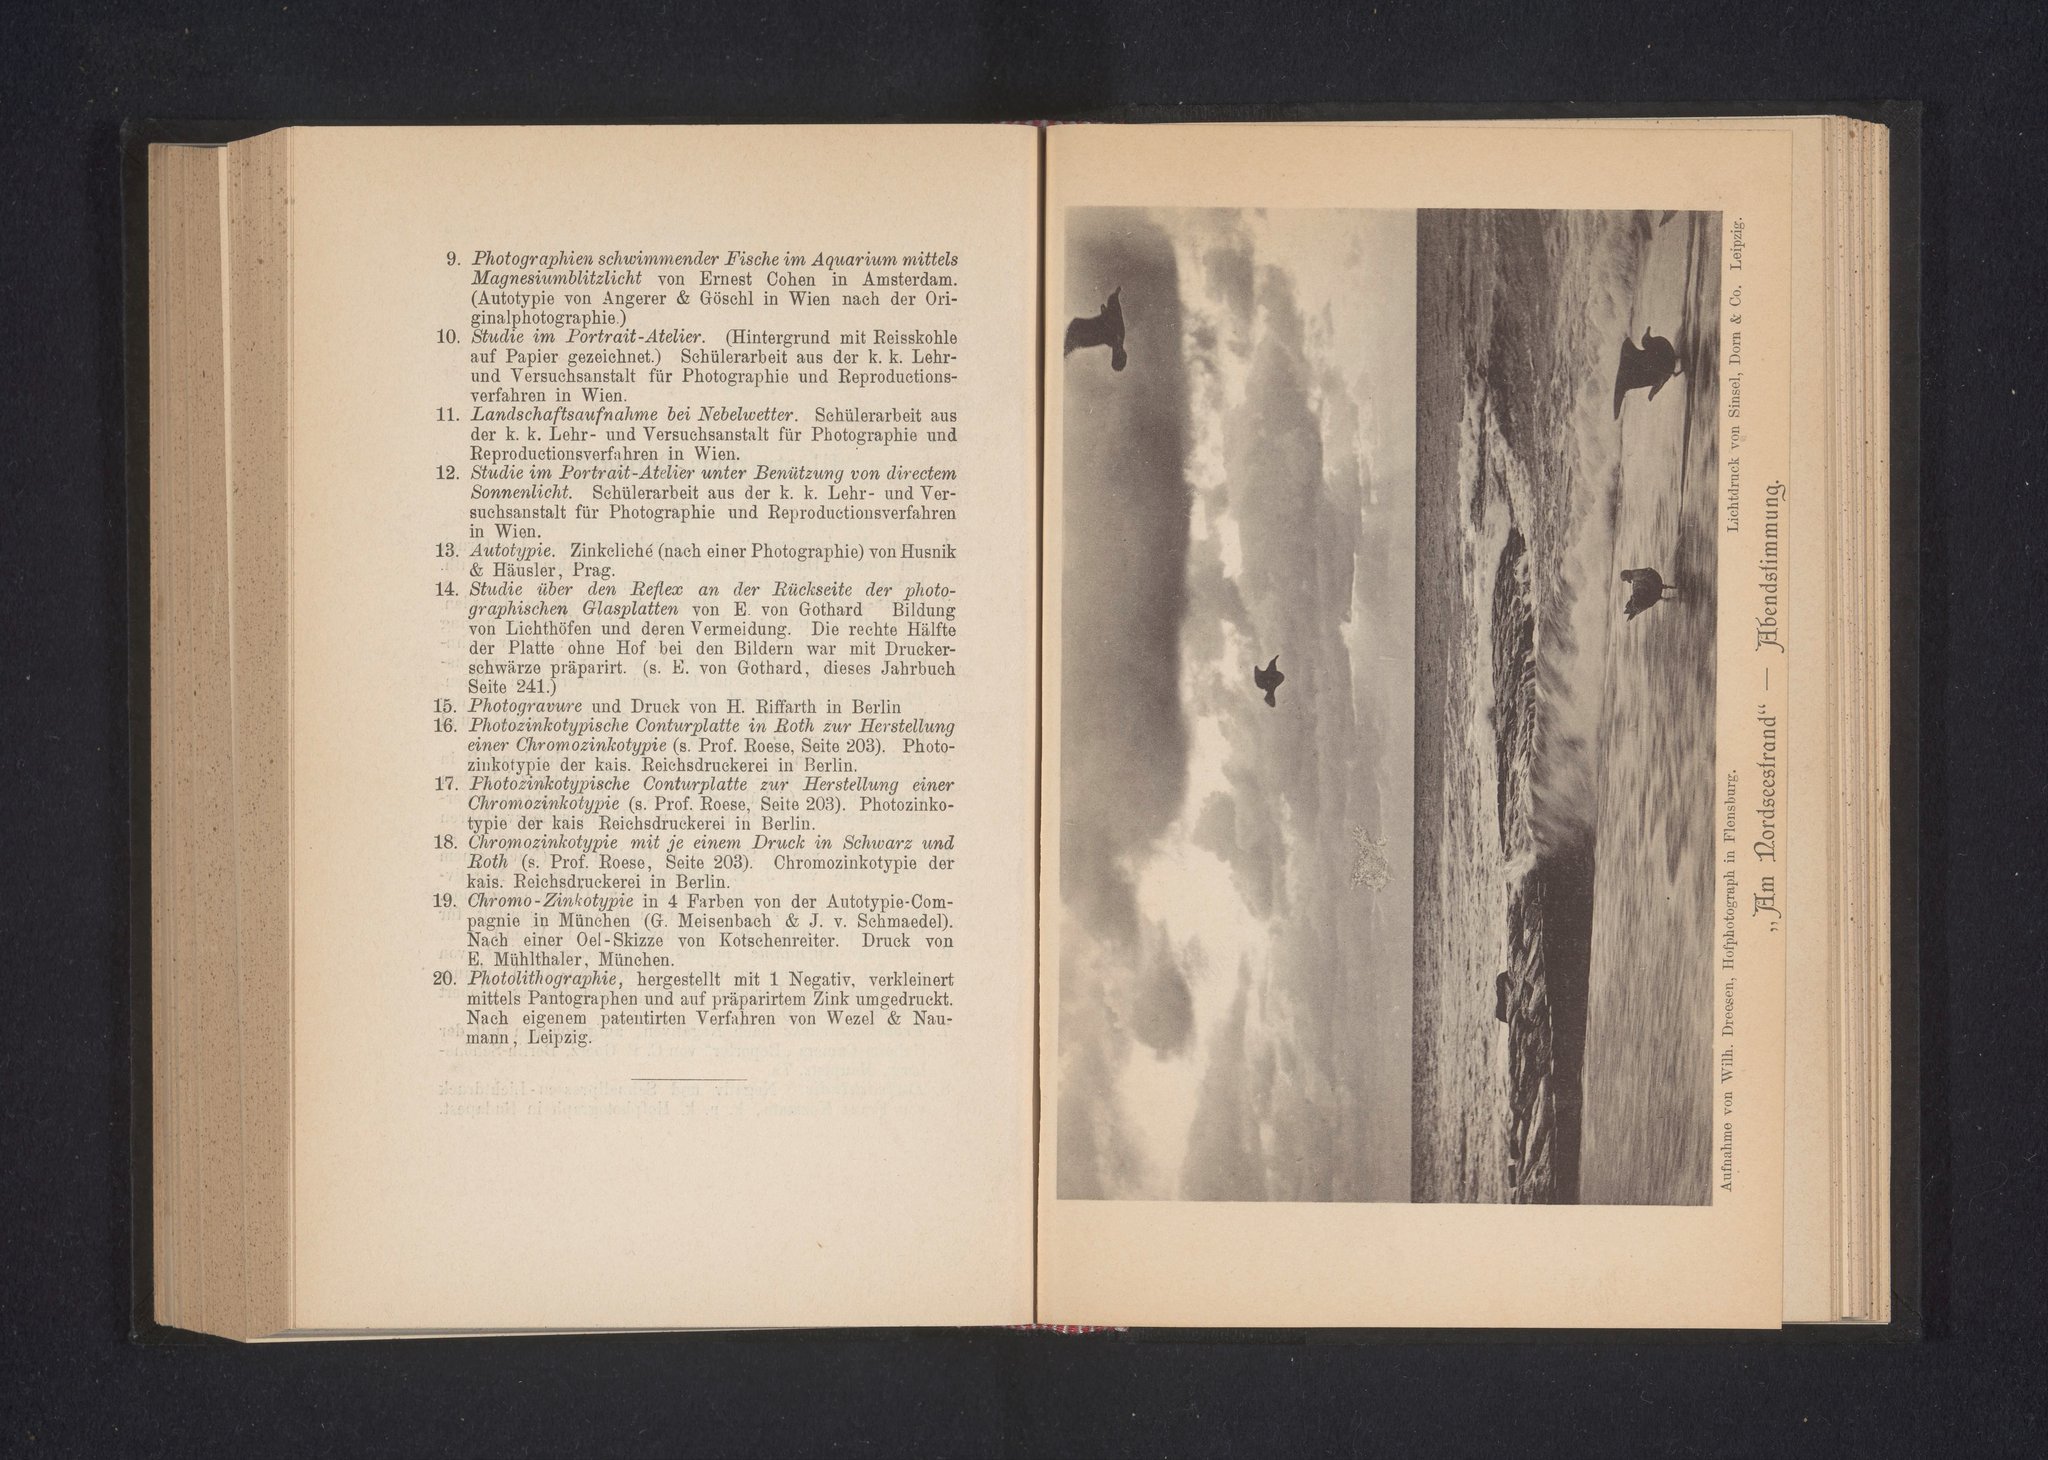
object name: page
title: Am Nordseestrand, Abendstimmung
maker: wilhelm dreesen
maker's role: fotograaf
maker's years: 1840-1926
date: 1885-1890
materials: paper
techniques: photograph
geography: leipzig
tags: shore-birds and wading-birds: gull, sea (seascape)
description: Prent op derde ongenummerde pagina na pagina 400.